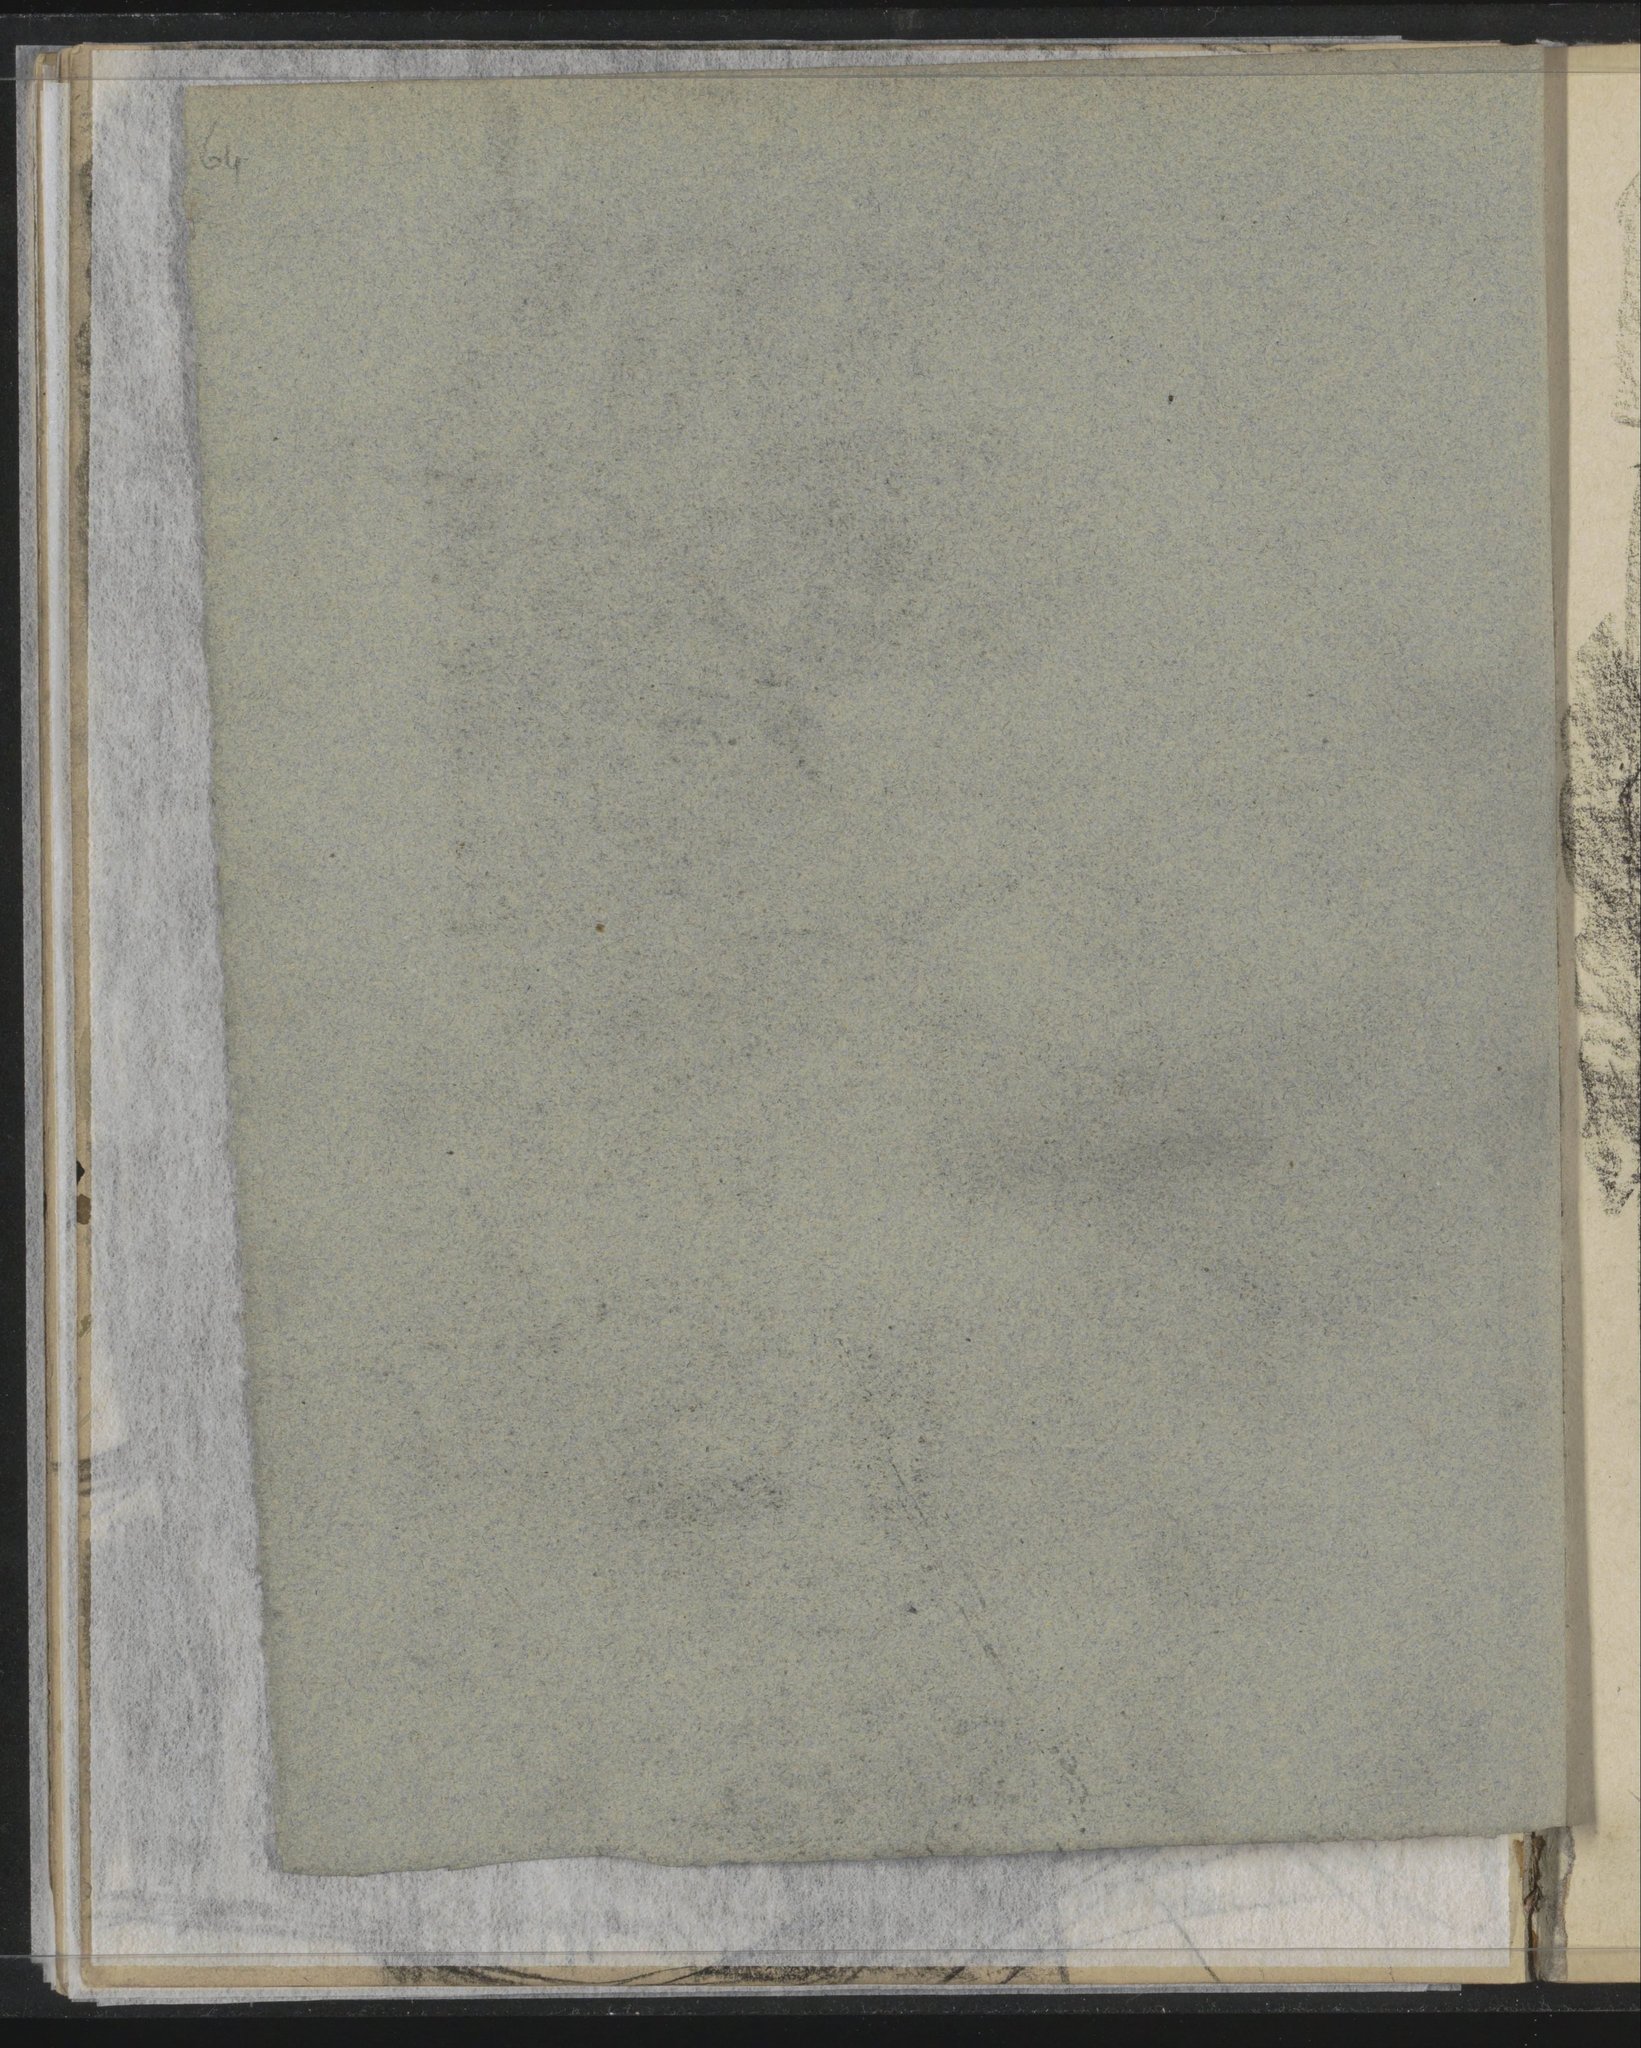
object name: sketchbook leaf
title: Abklatsch van de krijttekening op pagina 65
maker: willem witsen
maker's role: draughtsman, painter, print maker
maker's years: 1860-1923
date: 1887-1888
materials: paper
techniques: printmaking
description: Pagina 64 uit een schetsboek met 43 bladen.